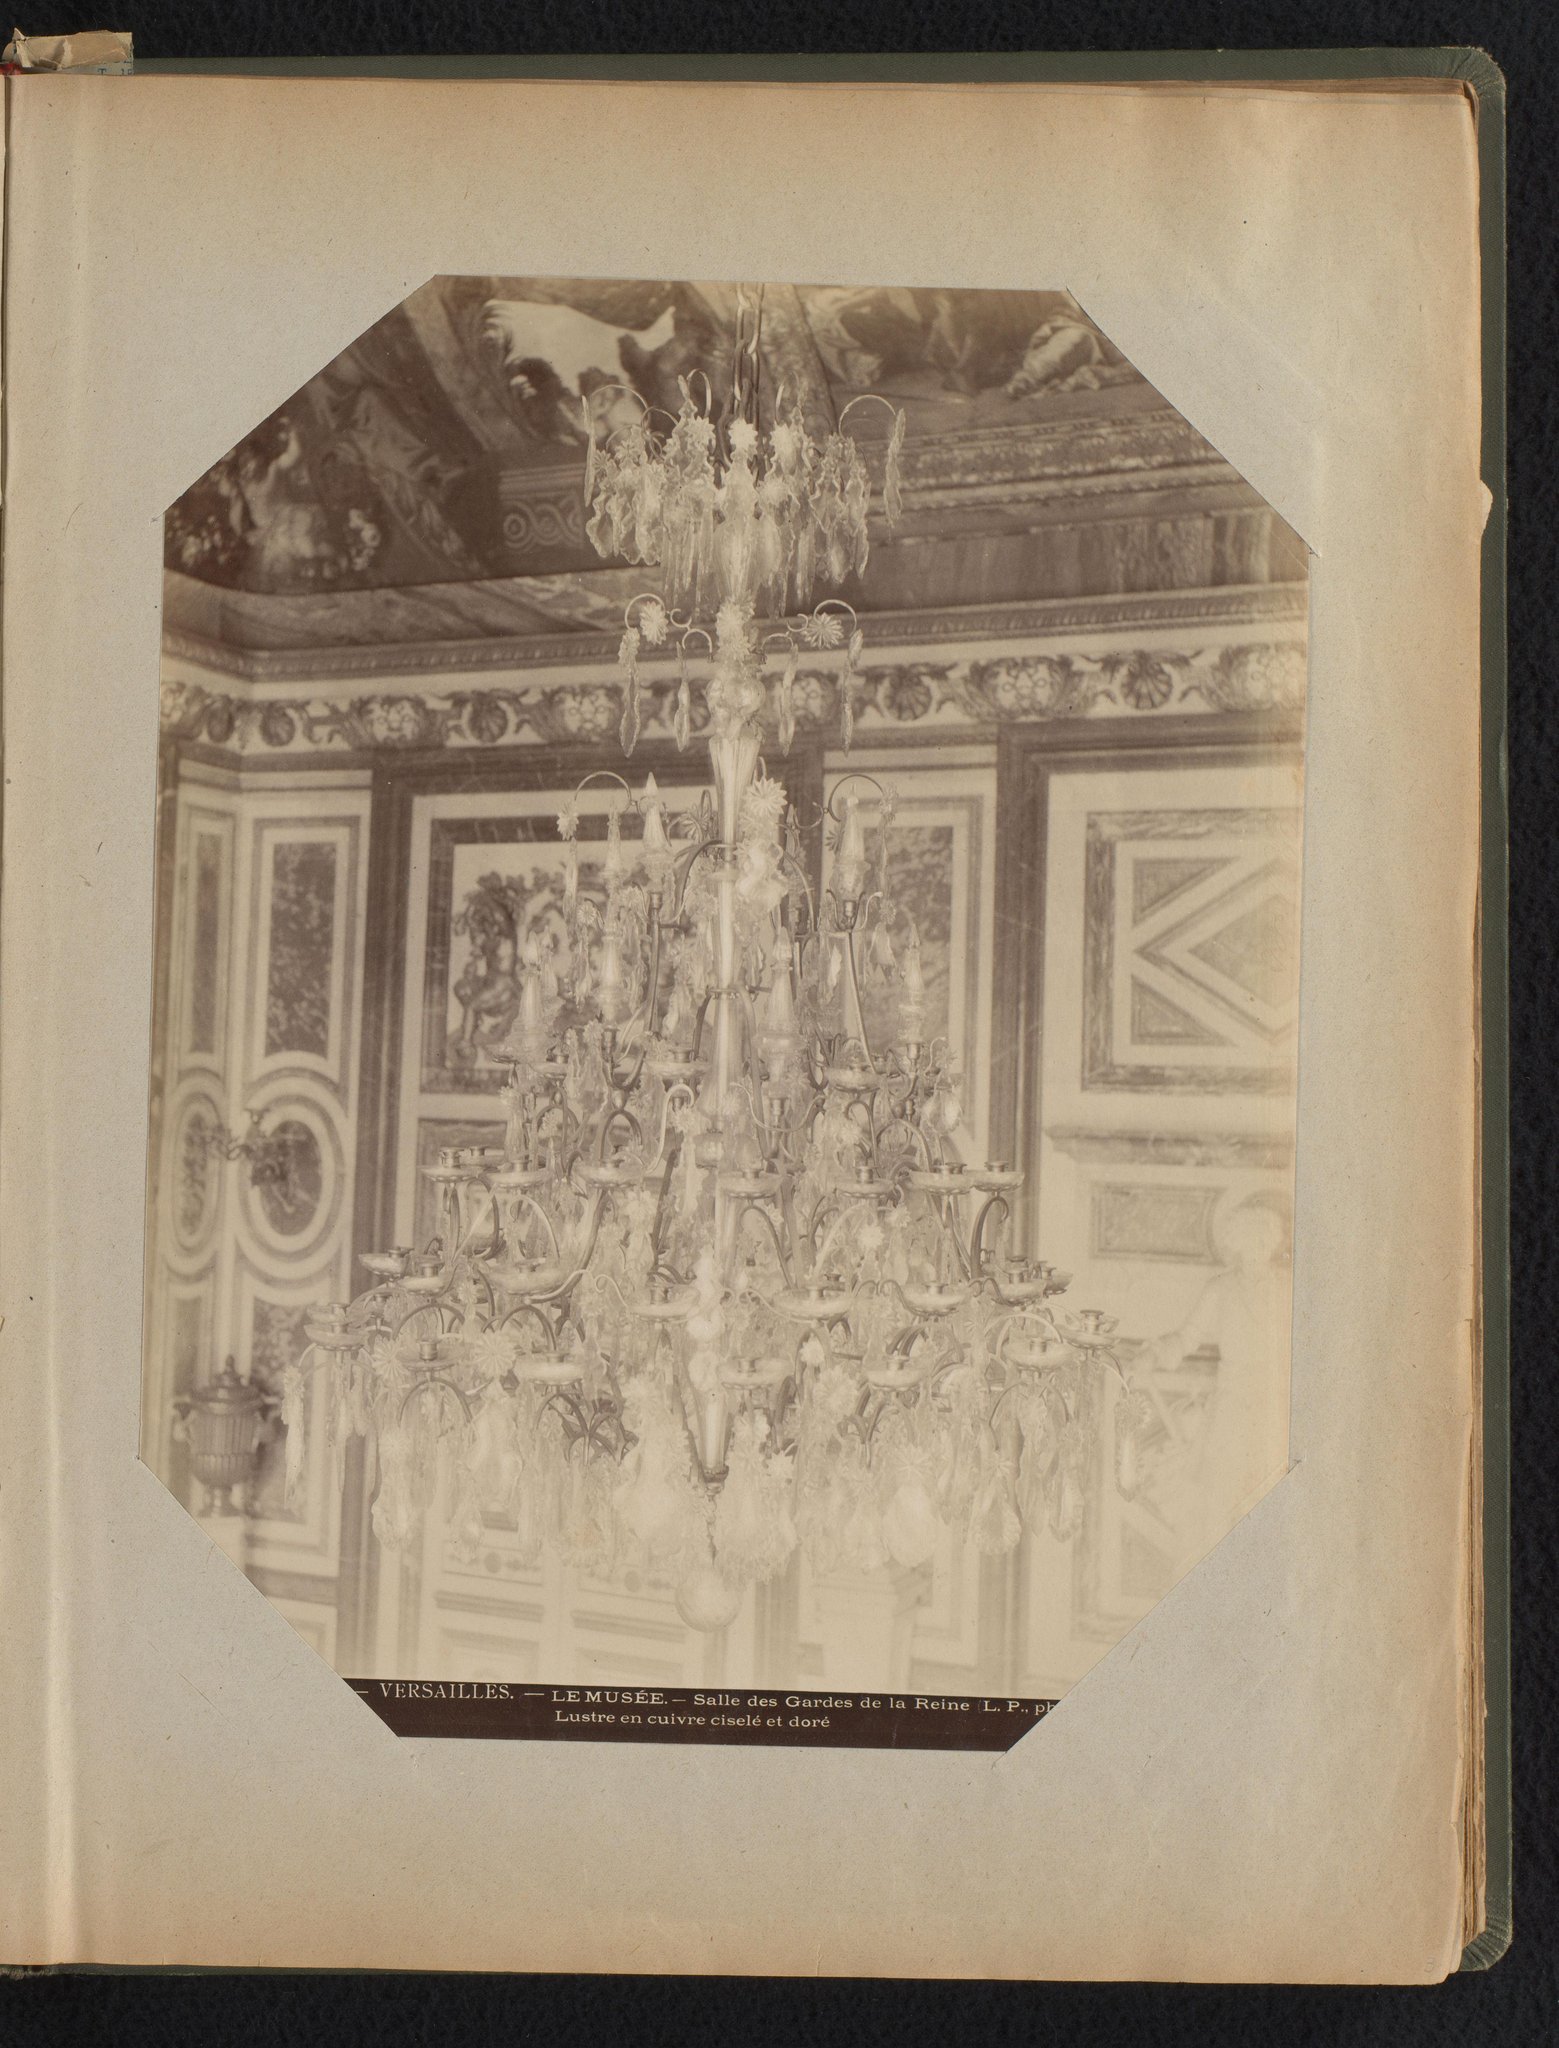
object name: photograph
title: 489. - Versailles - Le Musee. - Salle des gardes de la Reine L.P. phot. Lustre en cuivre cisele et dore.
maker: Anonymous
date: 1860-1900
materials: canvas, cardboard, paper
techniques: matte daylight collodion silver print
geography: netherlands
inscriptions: annotation: ‘489. - Versailles - Le Musee. - Salle des gardes de la Reine L.P. phot. Lustre en cuivre cisele et dore.’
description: Onderdeel van een serie met betrekking tot het interieur van het paleis van Versailles met kroonluchters, deuren, portalen en meubelstukken.